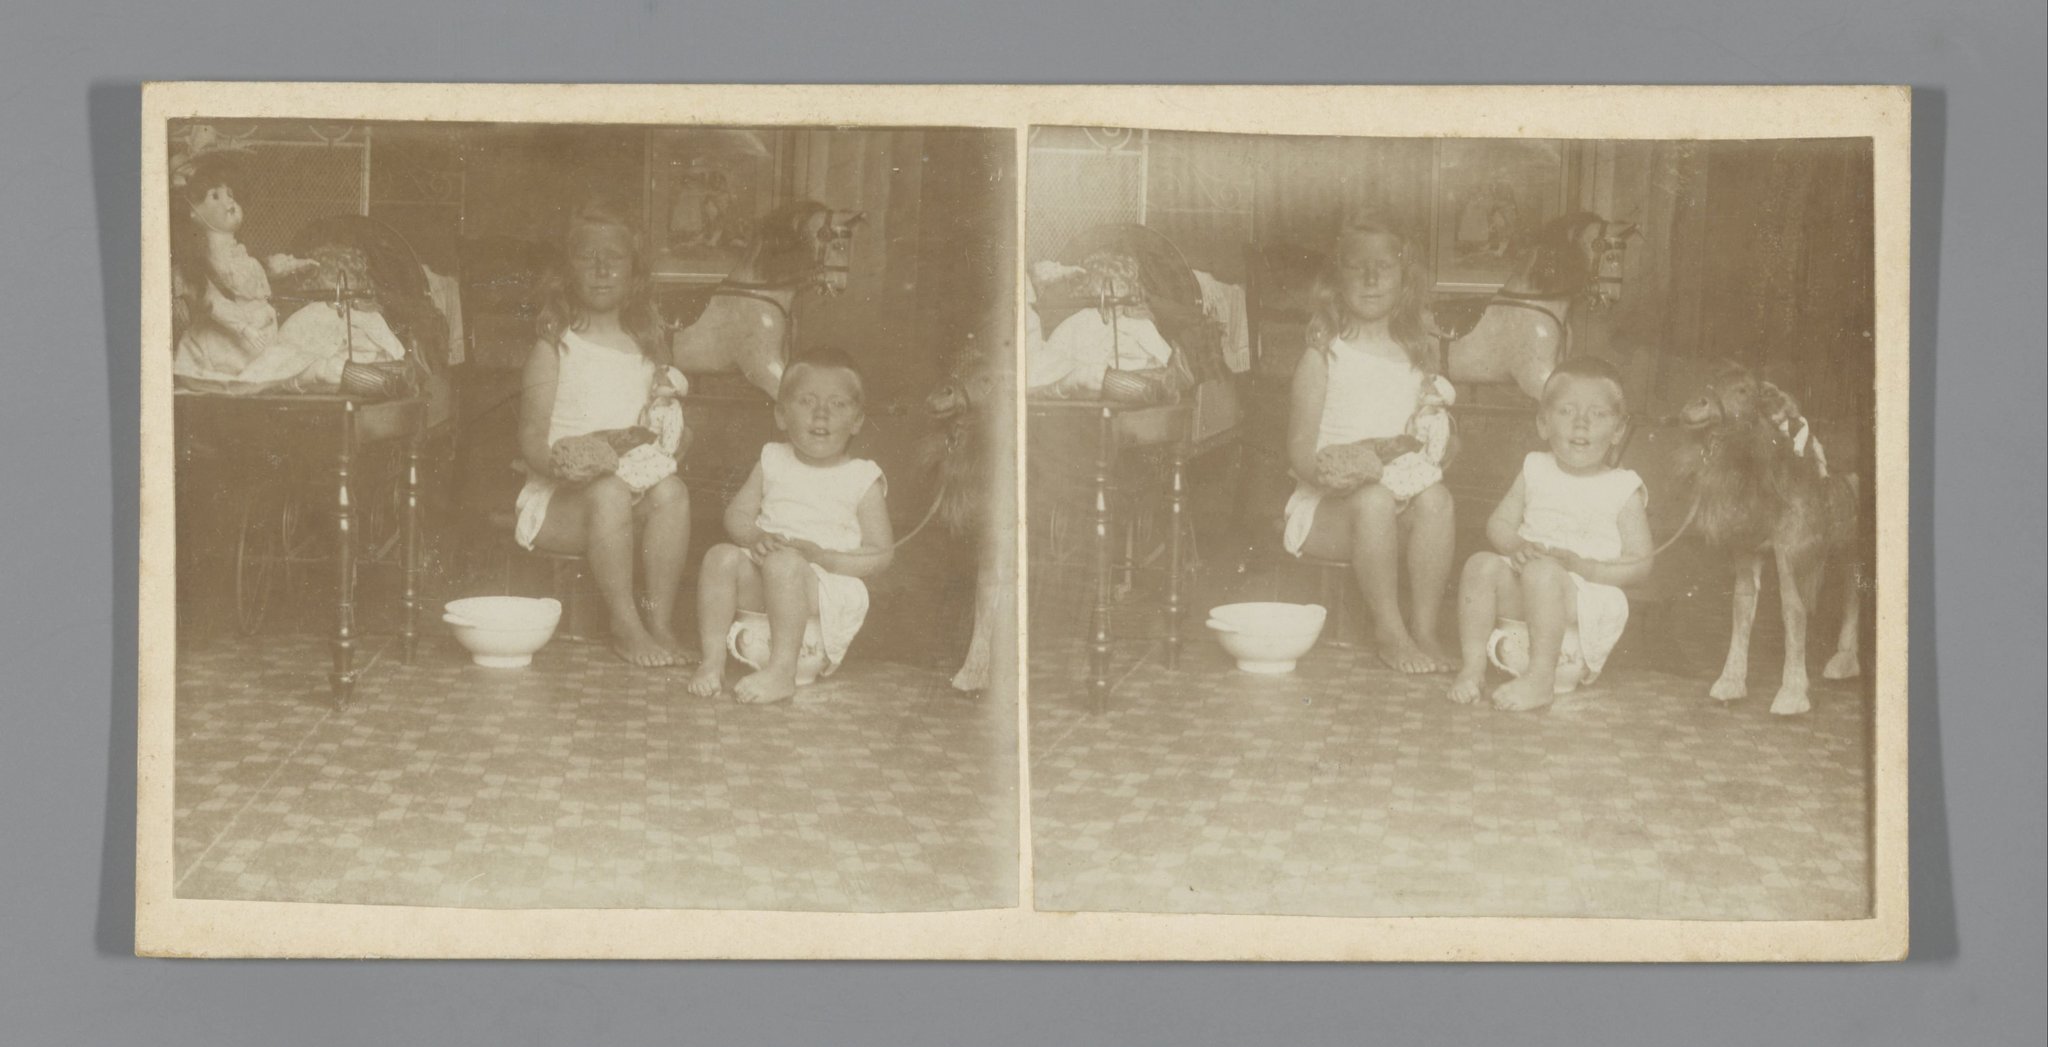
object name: stereograph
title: Twee kinderen op potjes omringd door speelgoed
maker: Anonymous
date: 1910-1920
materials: cardboard, photographic support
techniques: collodion silver print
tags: playing toddler; child amusing itself, interior of the house, chamber-pot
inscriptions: number: ‘24’